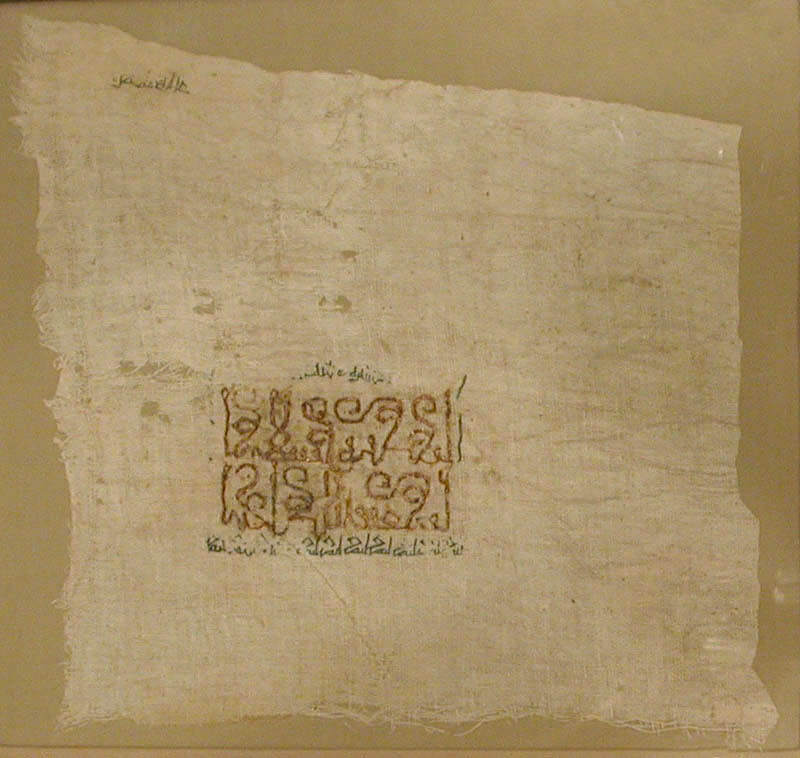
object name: textile fragment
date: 901-1000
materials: gold, linen, silk, thread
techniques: embroidery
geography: egypt